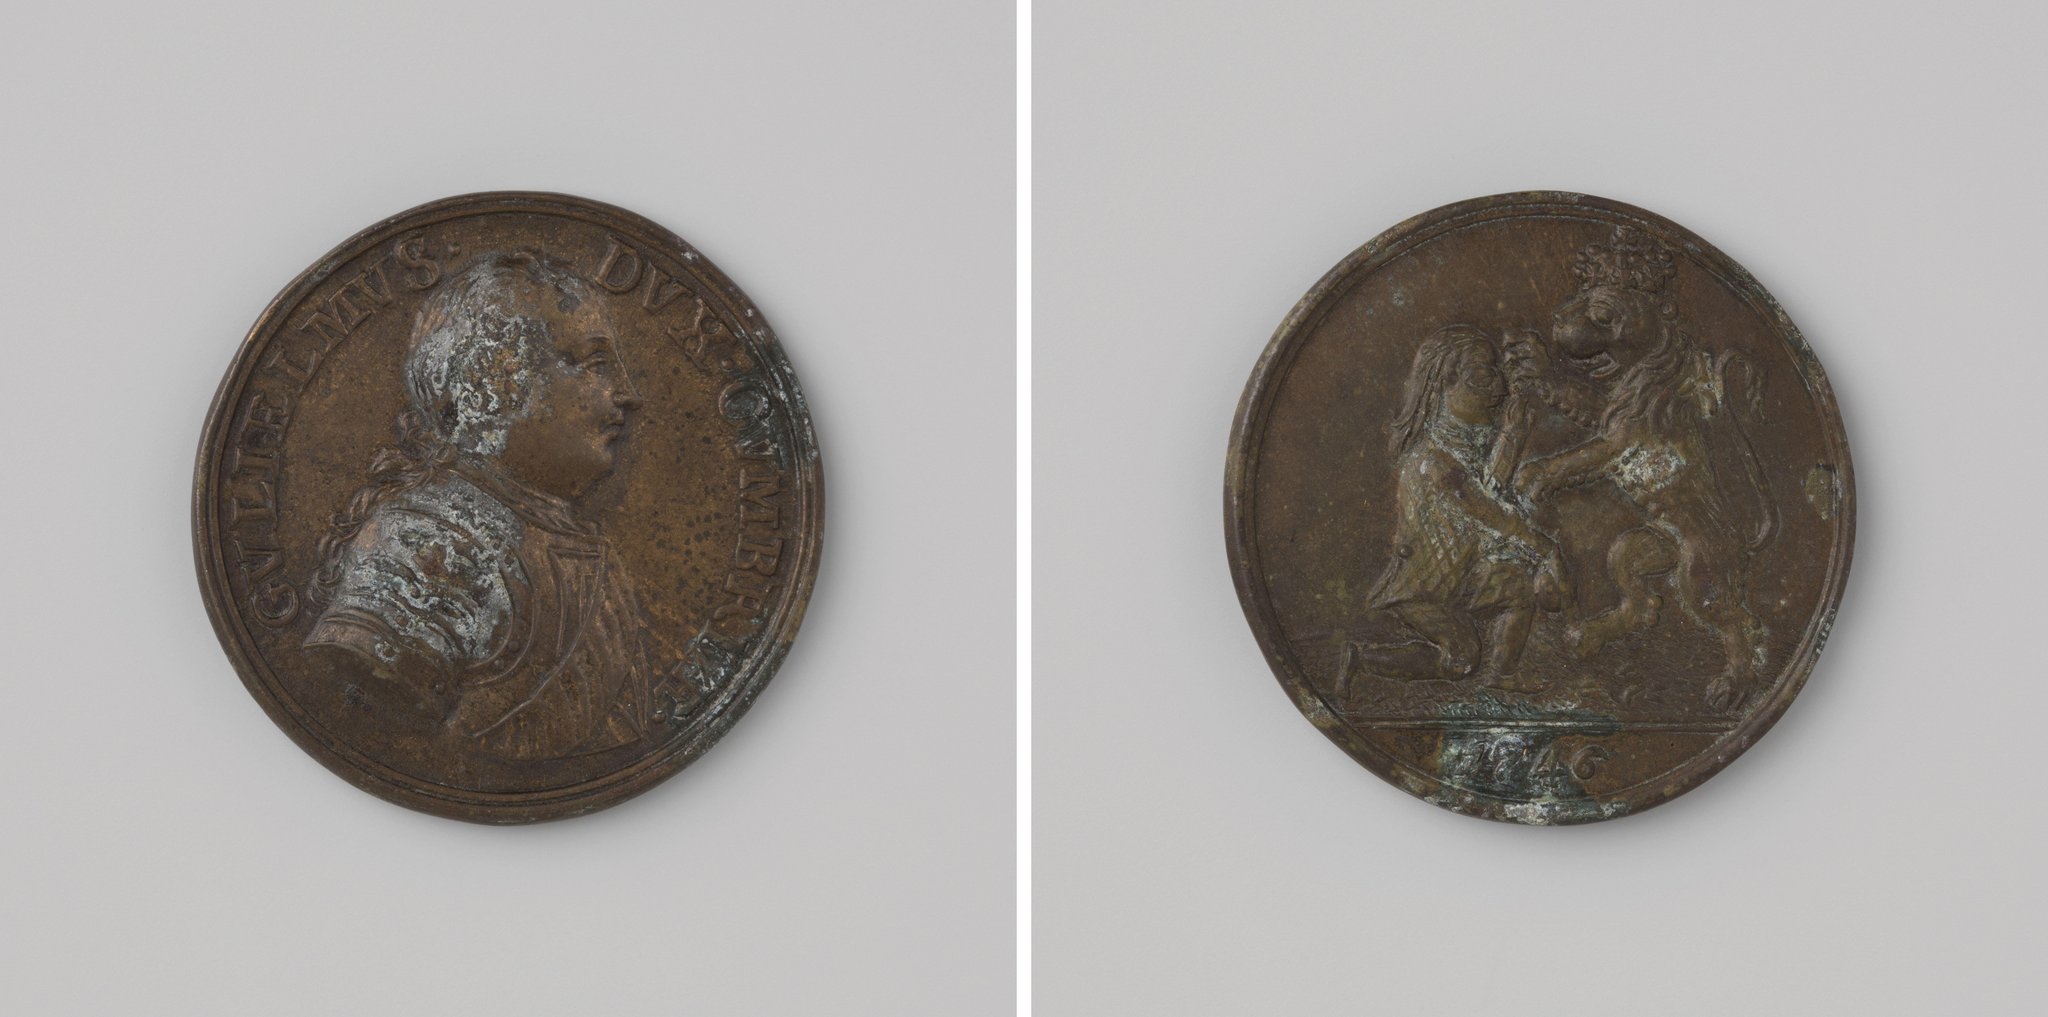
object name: history medal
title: Neerslaan van de opstand in Schotland, penning geslagen ter ere van Willem, hertog van Cumberland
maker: Anonymous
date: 1746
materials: copper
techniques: striking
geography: london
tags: prins, admiraal, willem van cumberland (hertog), schotland, schotse opstand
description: Koperen penning. Voorzijde: borststuk man binnen omschrift. Keerzijde: Schotse Highlander met ontbloot hoofd knielend voor staande leeuw; afsnede: jaartal